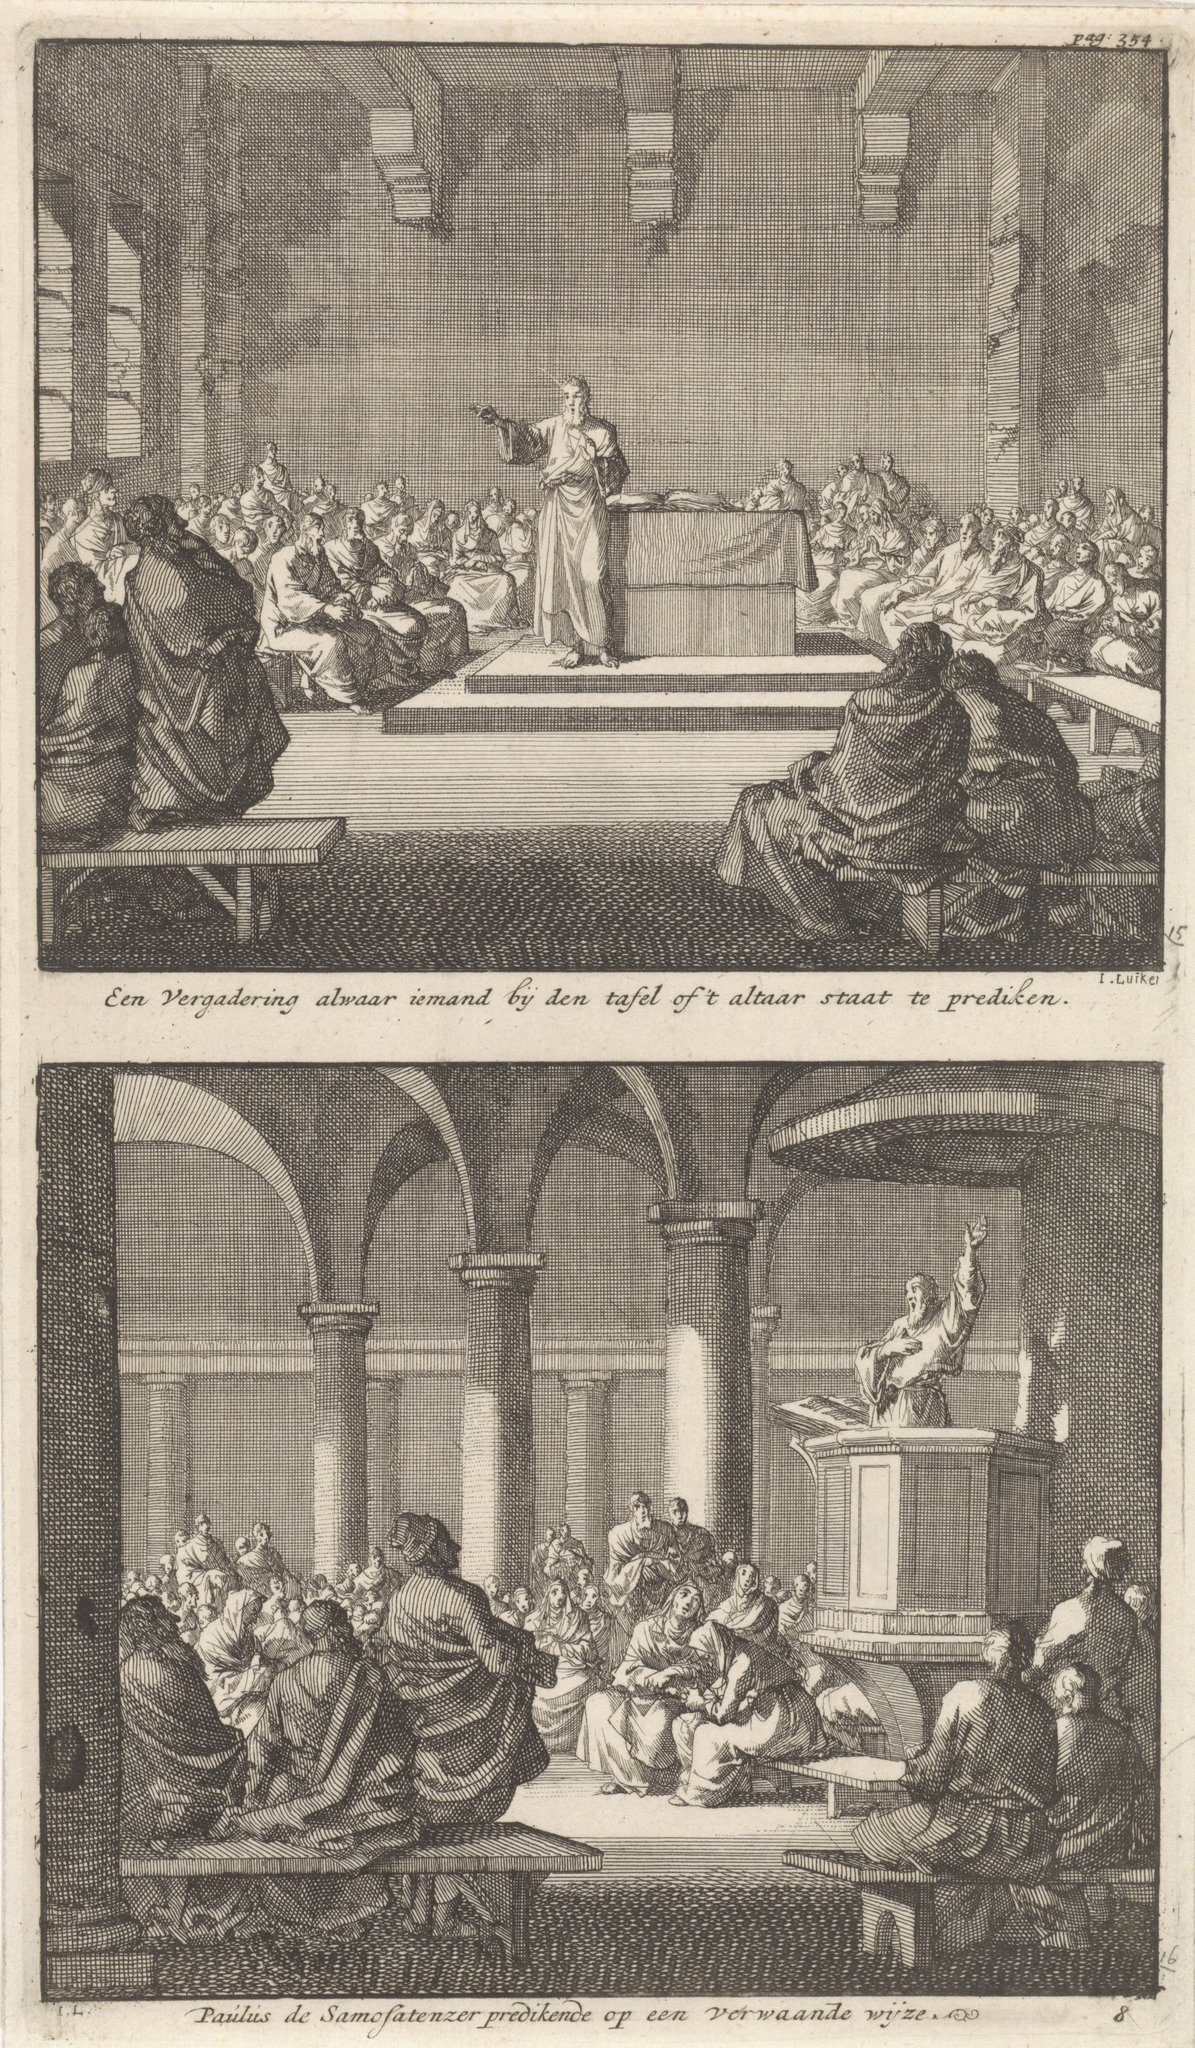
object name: book illustration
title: Een Vergadering alwaar iemand bij den tafel of 't altaar staat te prediken / Paulus de Samosatenzer predikende op een verwaande wijze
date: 1700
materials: paper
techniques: etching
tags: the early christian churches, e.g. armenians, copts, syrians, preaching (in general), altar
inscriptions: collector's mark: Lugt 2228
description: Twee voorstellingen op een plaat. Boven: voor een altaar predikt een priester voor de gemeenschap van vroege christenen. Onder: het interieur van een kerk. Op het preekgestoelte staat Paulus van Samosata. Hij predikt hooghartig voor de vroeg-christelijke gemeenschap.